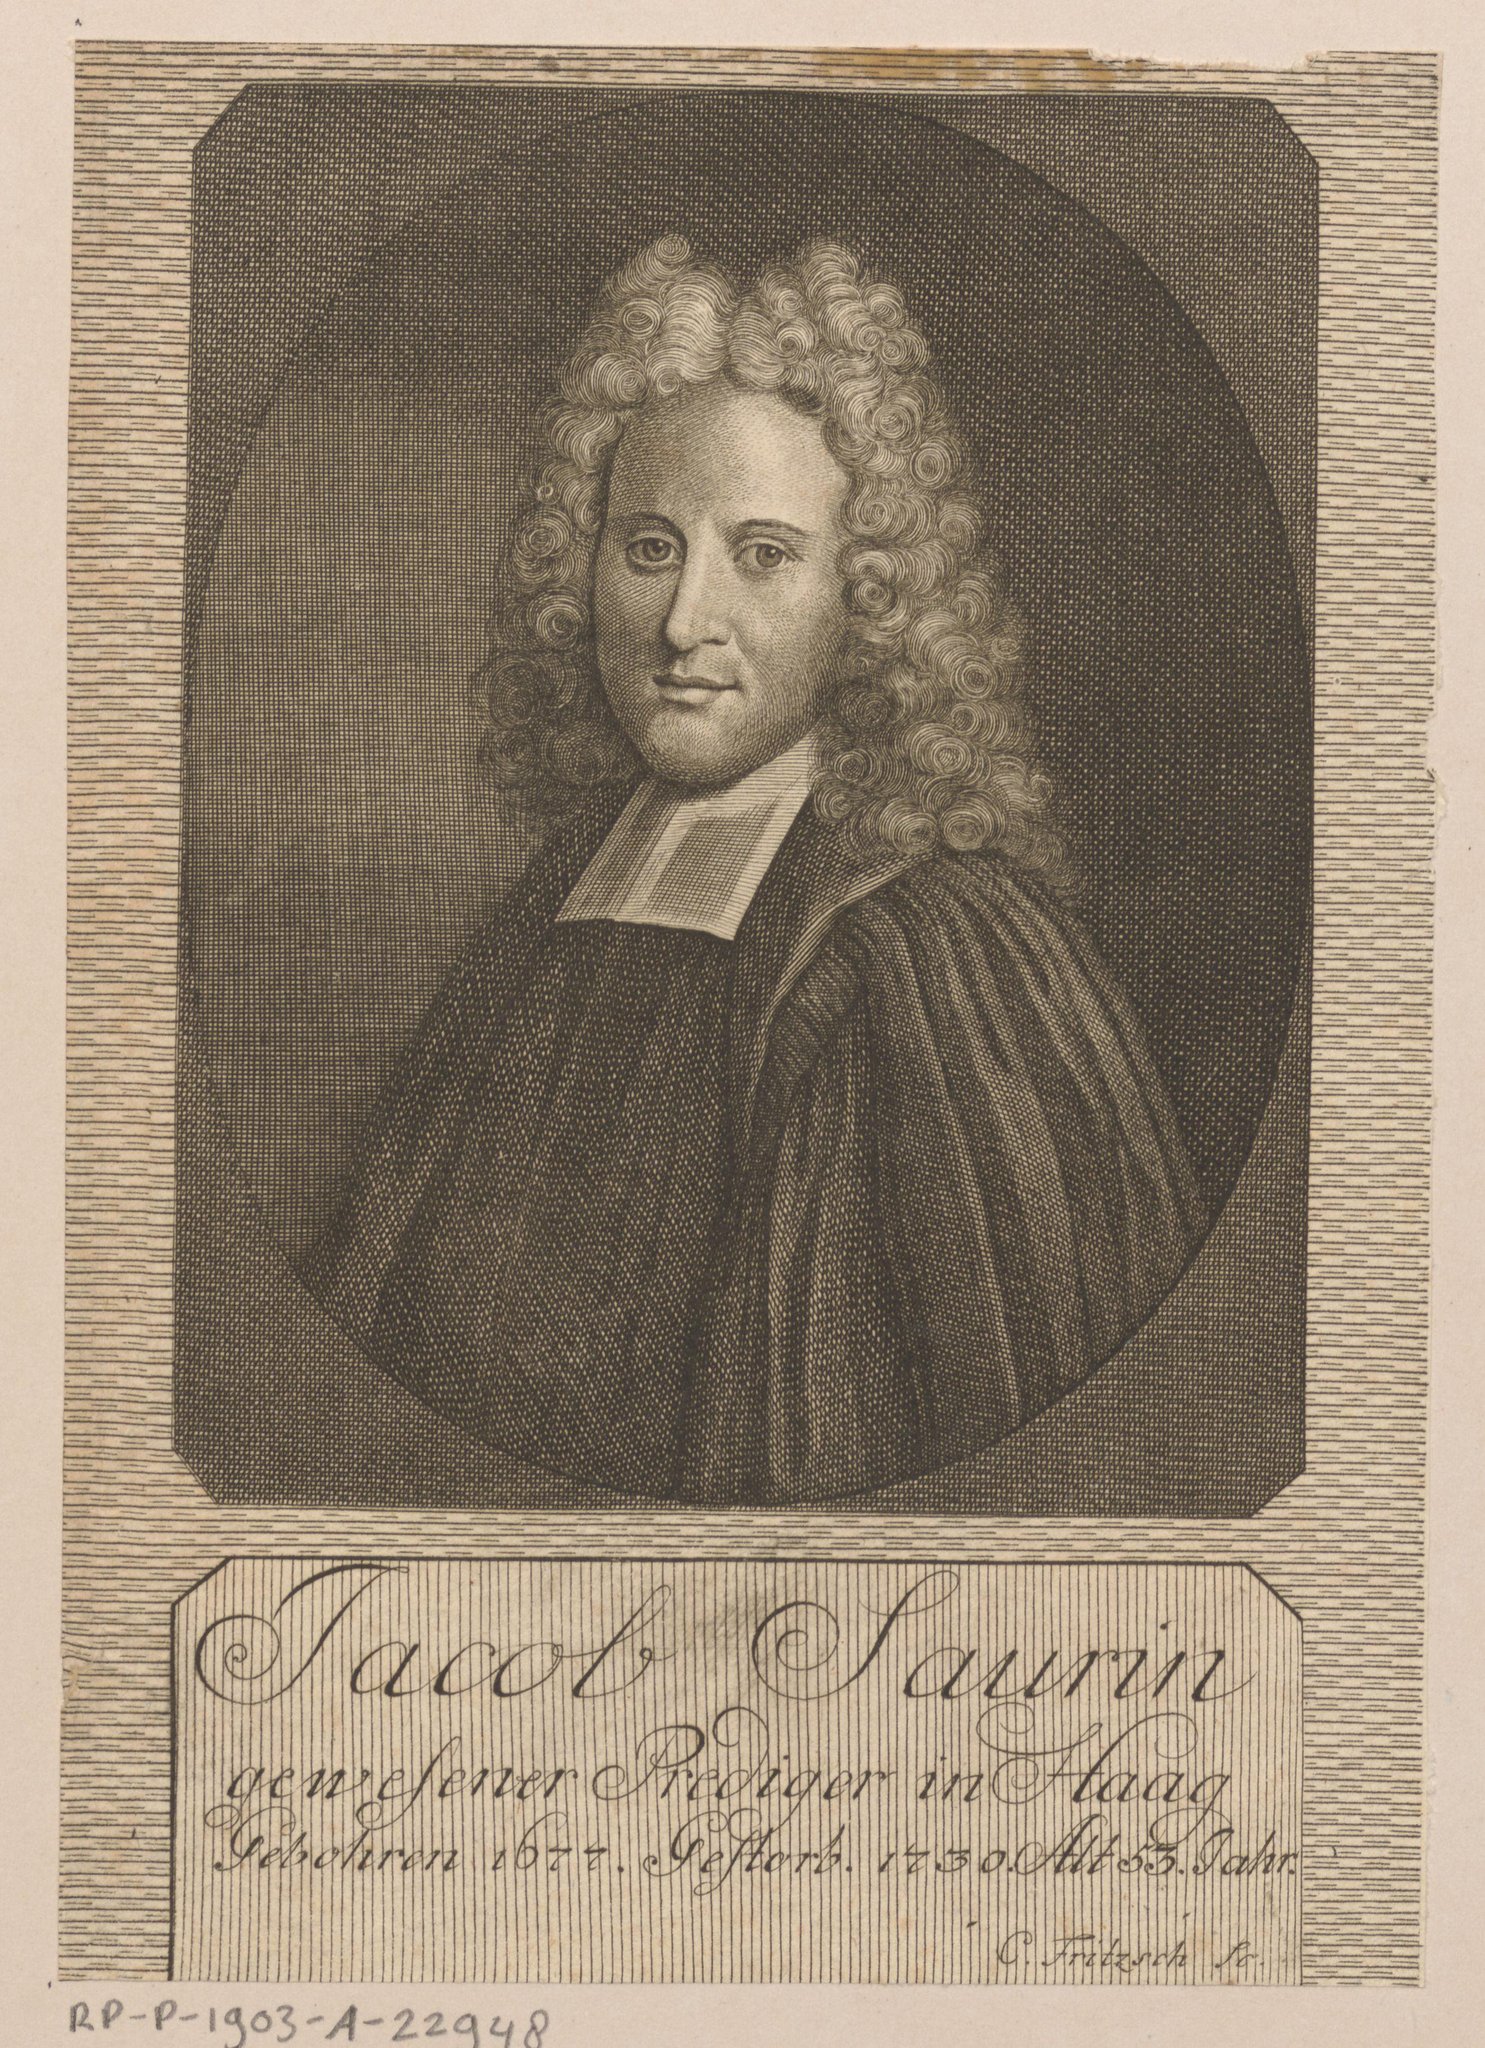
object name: print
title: Portret van Jacques Saurin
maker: christian friedrich fritzsch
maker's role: print maker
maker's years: 1719-1774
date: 1745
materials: paper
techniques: engraving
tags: the hague, protestant churches and denominations, historical persons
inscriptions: collector's mark: Lugt 2228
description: Prent mogelijk uit: Saurin, Jacques. Betrachtungen über die Wichtigsten Begebenheiten des Alten und Neuen Testaments (...). Rostock: Johann Christian Koppe 1745, dl. 1.